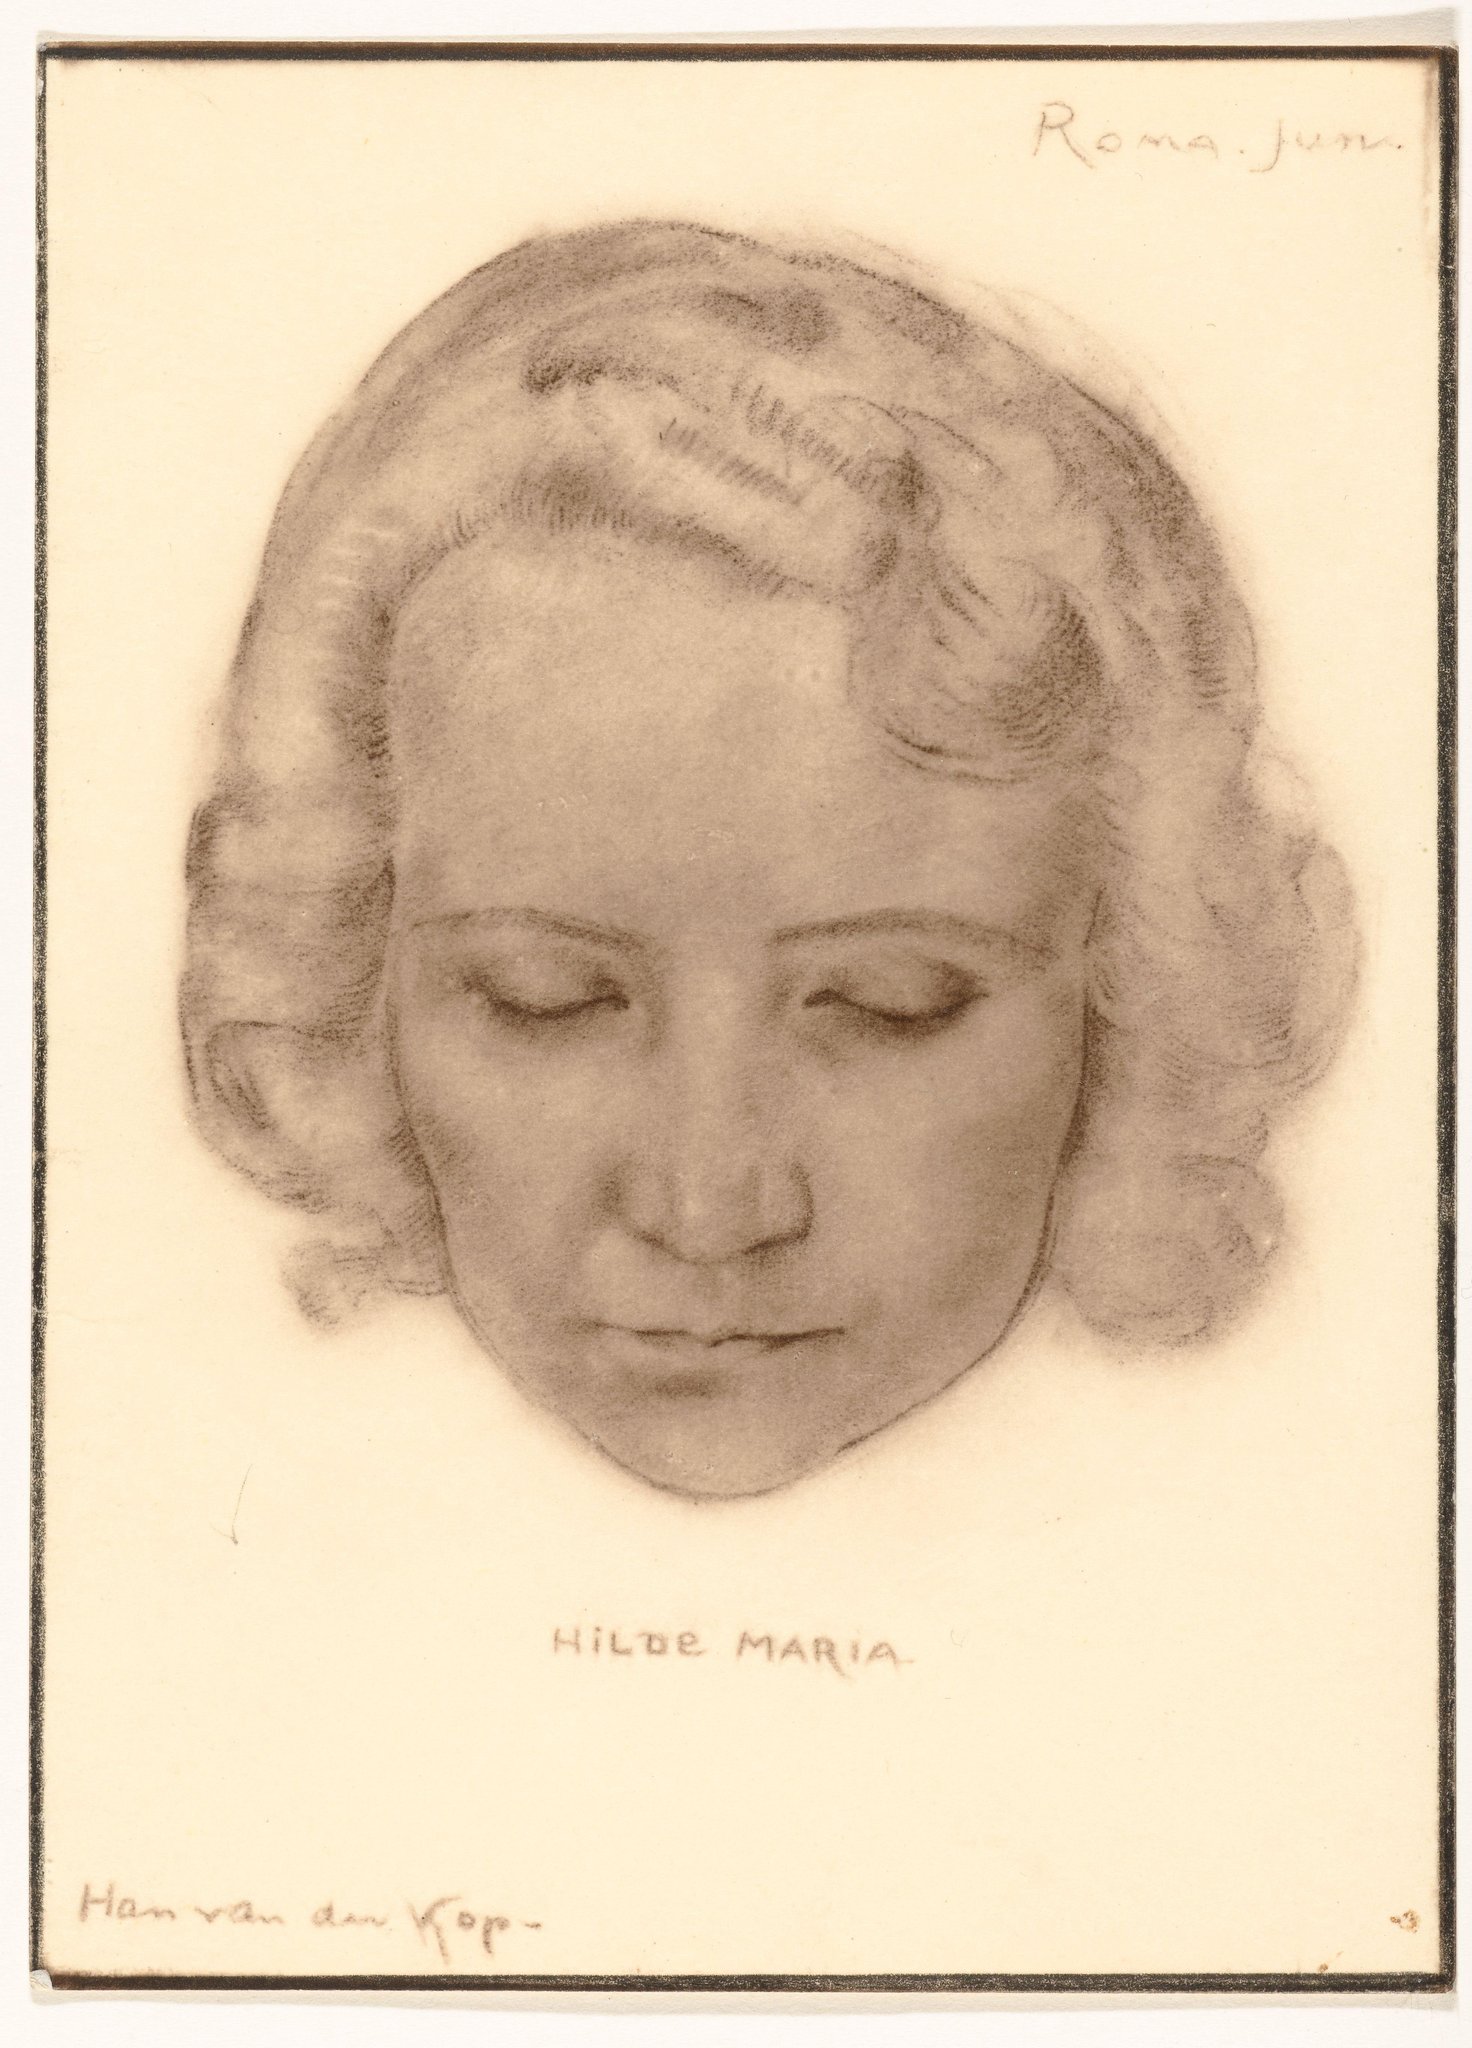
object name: photograph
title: Fotoreproductie van een portret van Hilde Maria door Han van der Kop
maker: adriaan bijl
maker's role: fotograaf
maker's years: 1874-1967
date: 1933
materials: paper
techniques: gelatin silver print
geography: amsterdam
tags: drawing, historical persons - bb - woman, girl (child between toddler and youth)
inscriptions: annotation: ‘Reproductie van nagelaten werk van Han van der Kop’